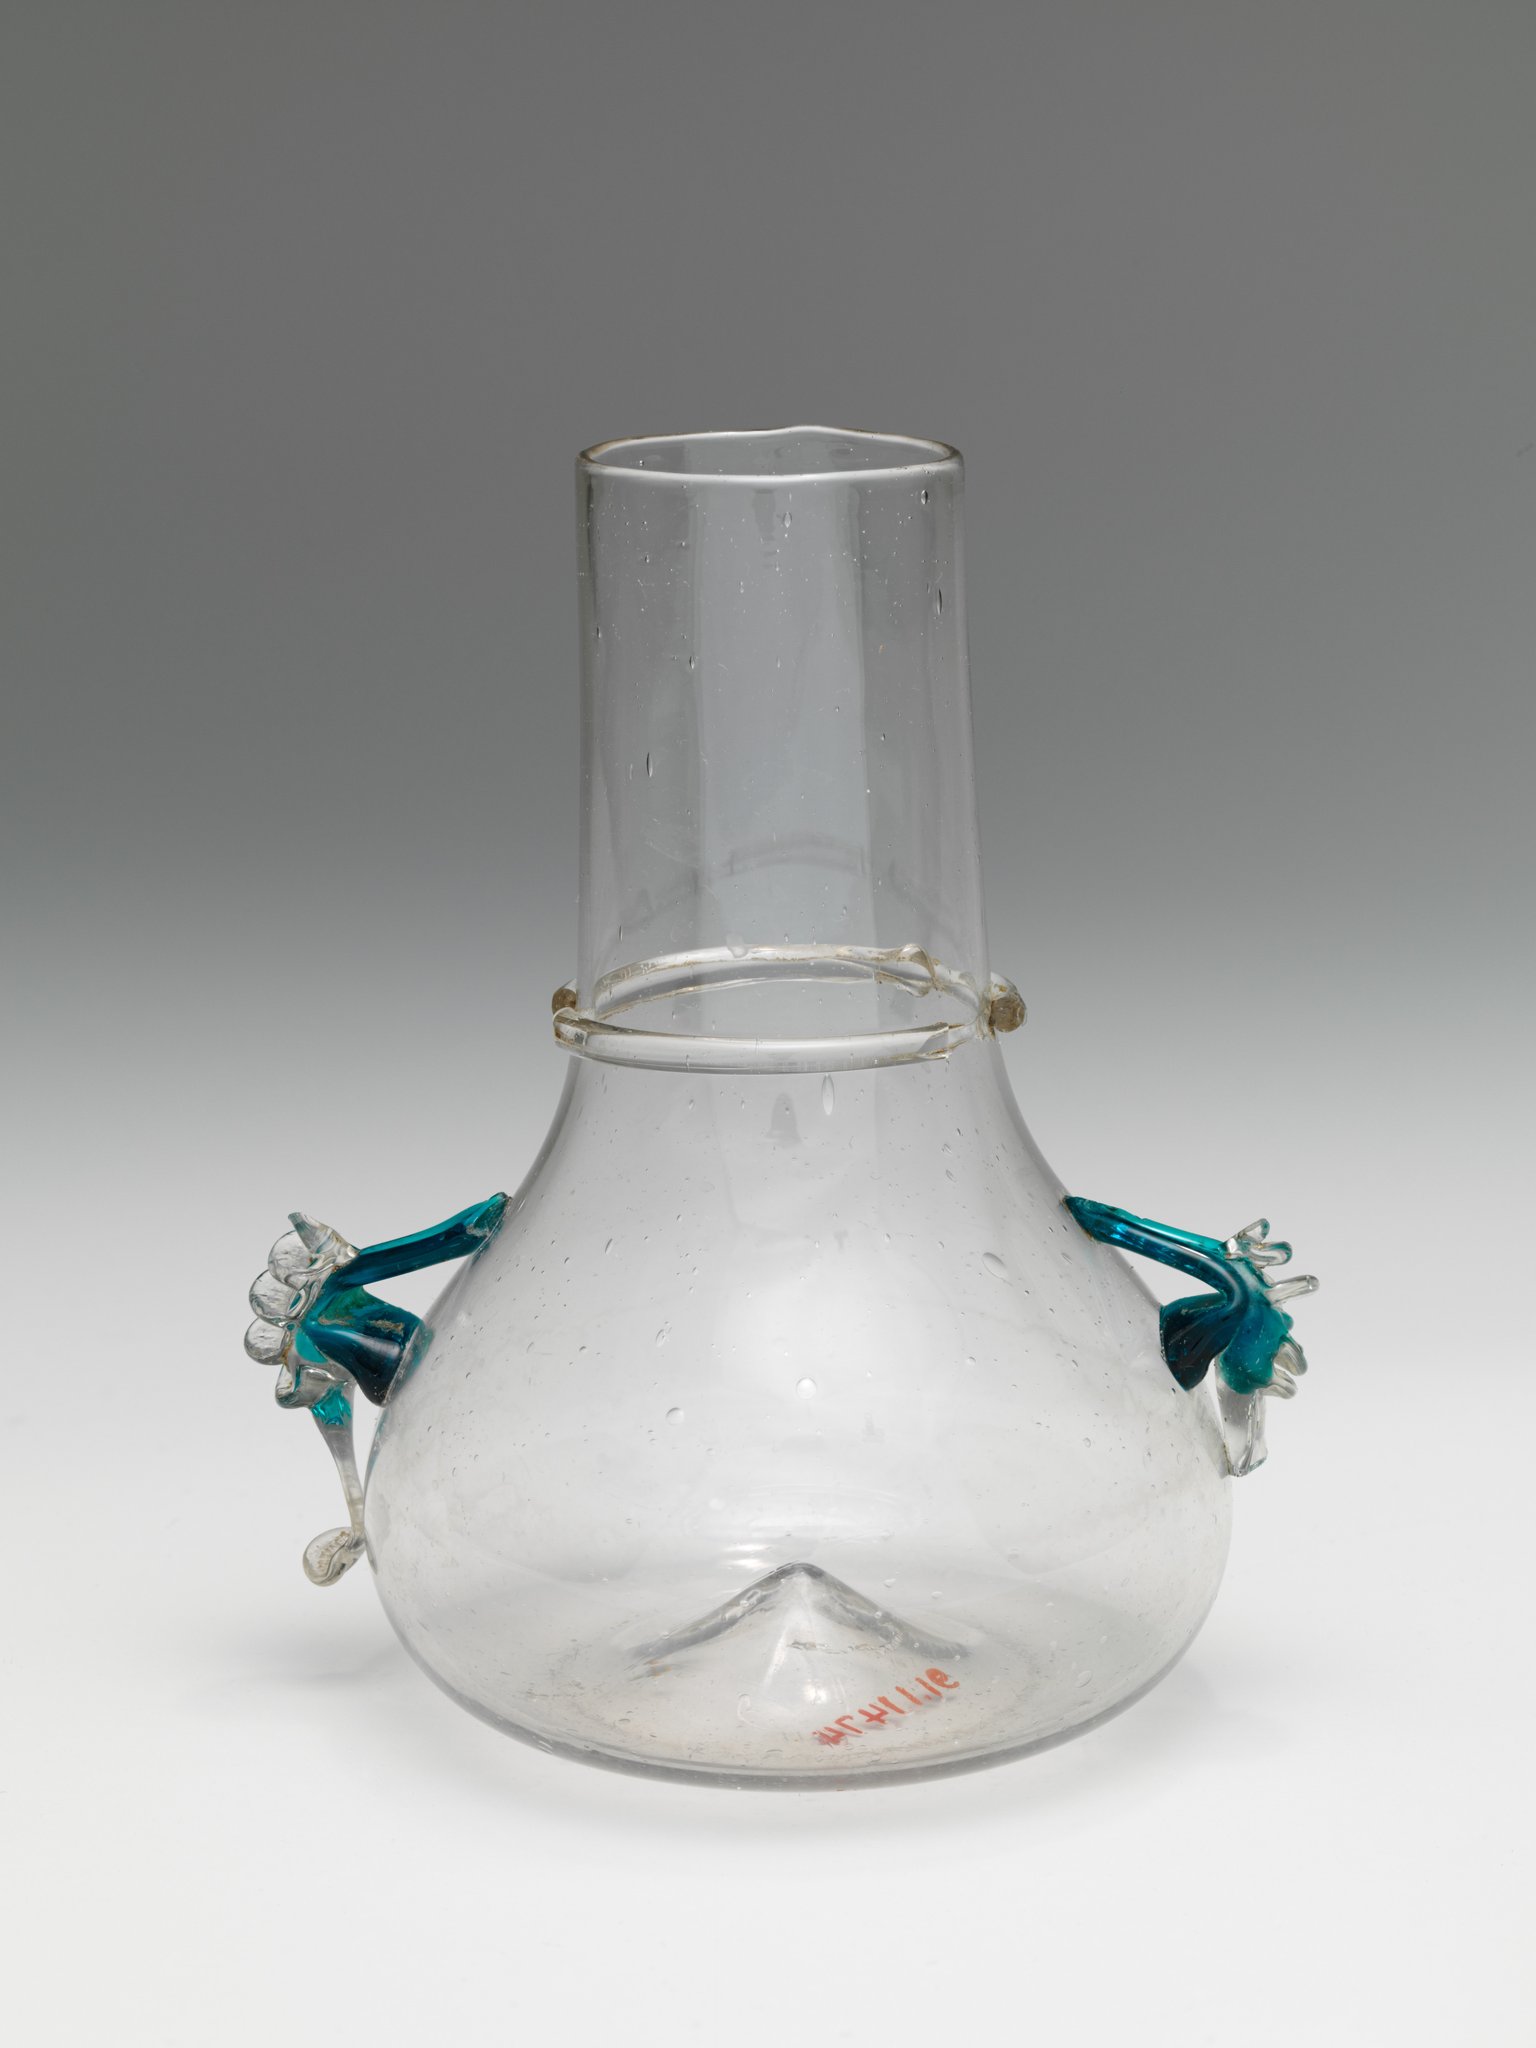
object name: bottle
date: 1601-1700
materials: glass